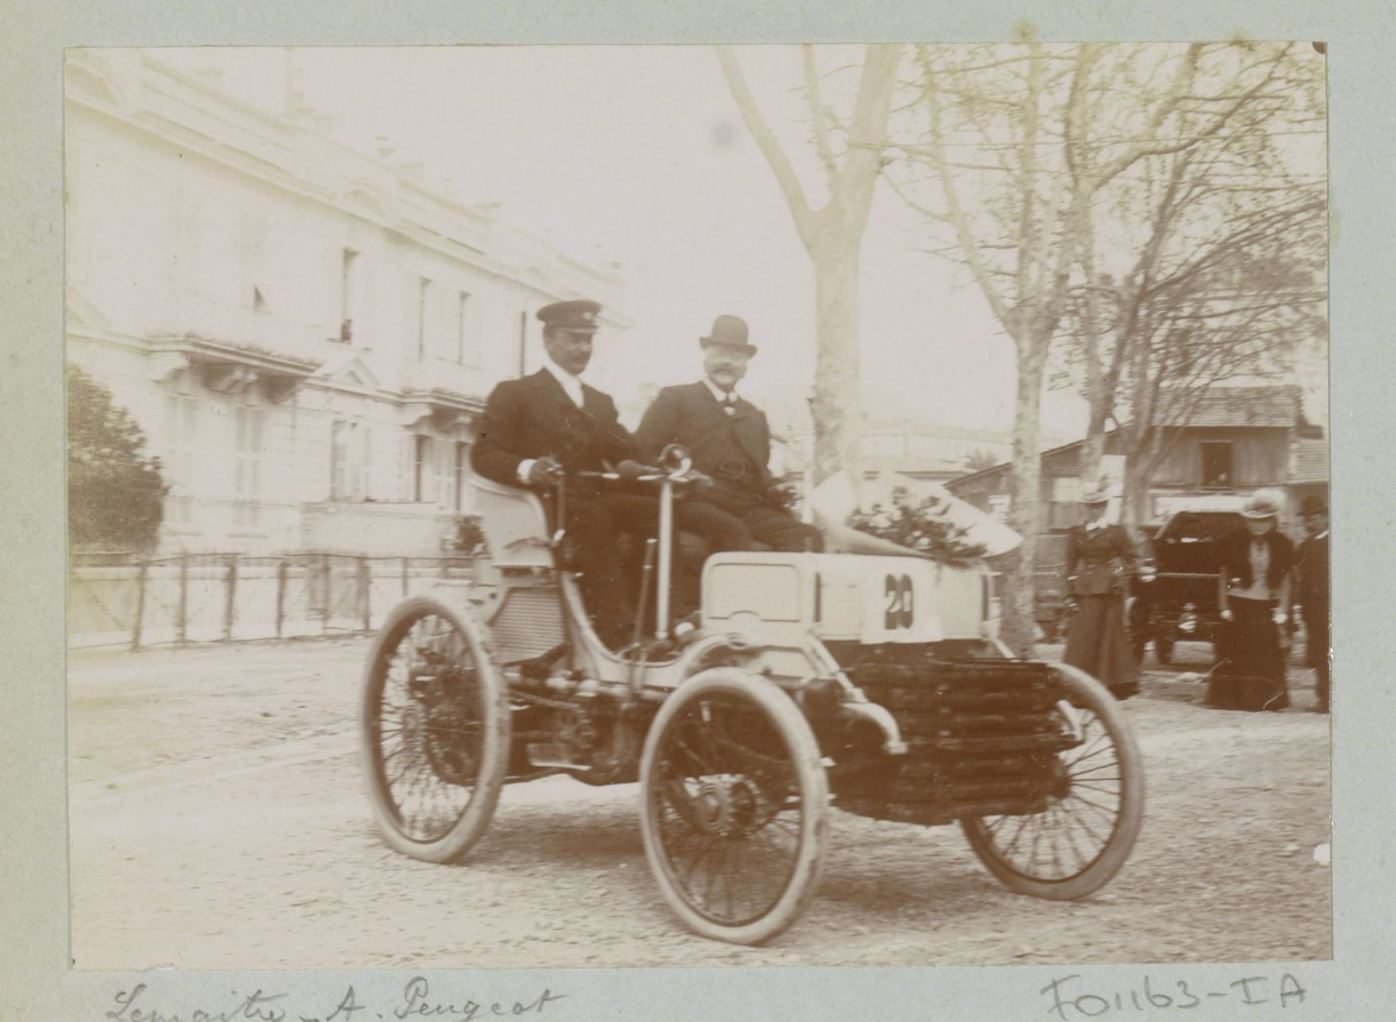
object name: photograph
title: Lemaître en A. Peugeot in een automobiel, vermoedelijk bij de Course du Mille, een race in Nice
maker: delizy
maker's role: manufacturer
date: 1899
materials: paper, photographic support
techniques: gelatin silver print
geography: nice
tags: motorcar racing, automobile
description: Onderdeel van Fotoalbum van een Franse amateurfotograaf met opnames van uitstapjes in Frankrijk, Spanje, België, Luxemburg en Nederland, de eerste automobielen en autoraces.